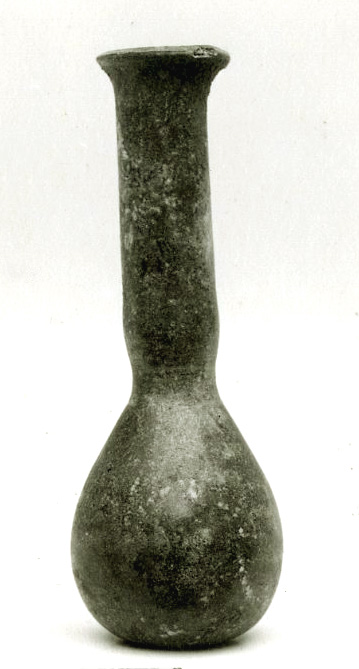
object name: vessel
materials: glass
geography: nubia